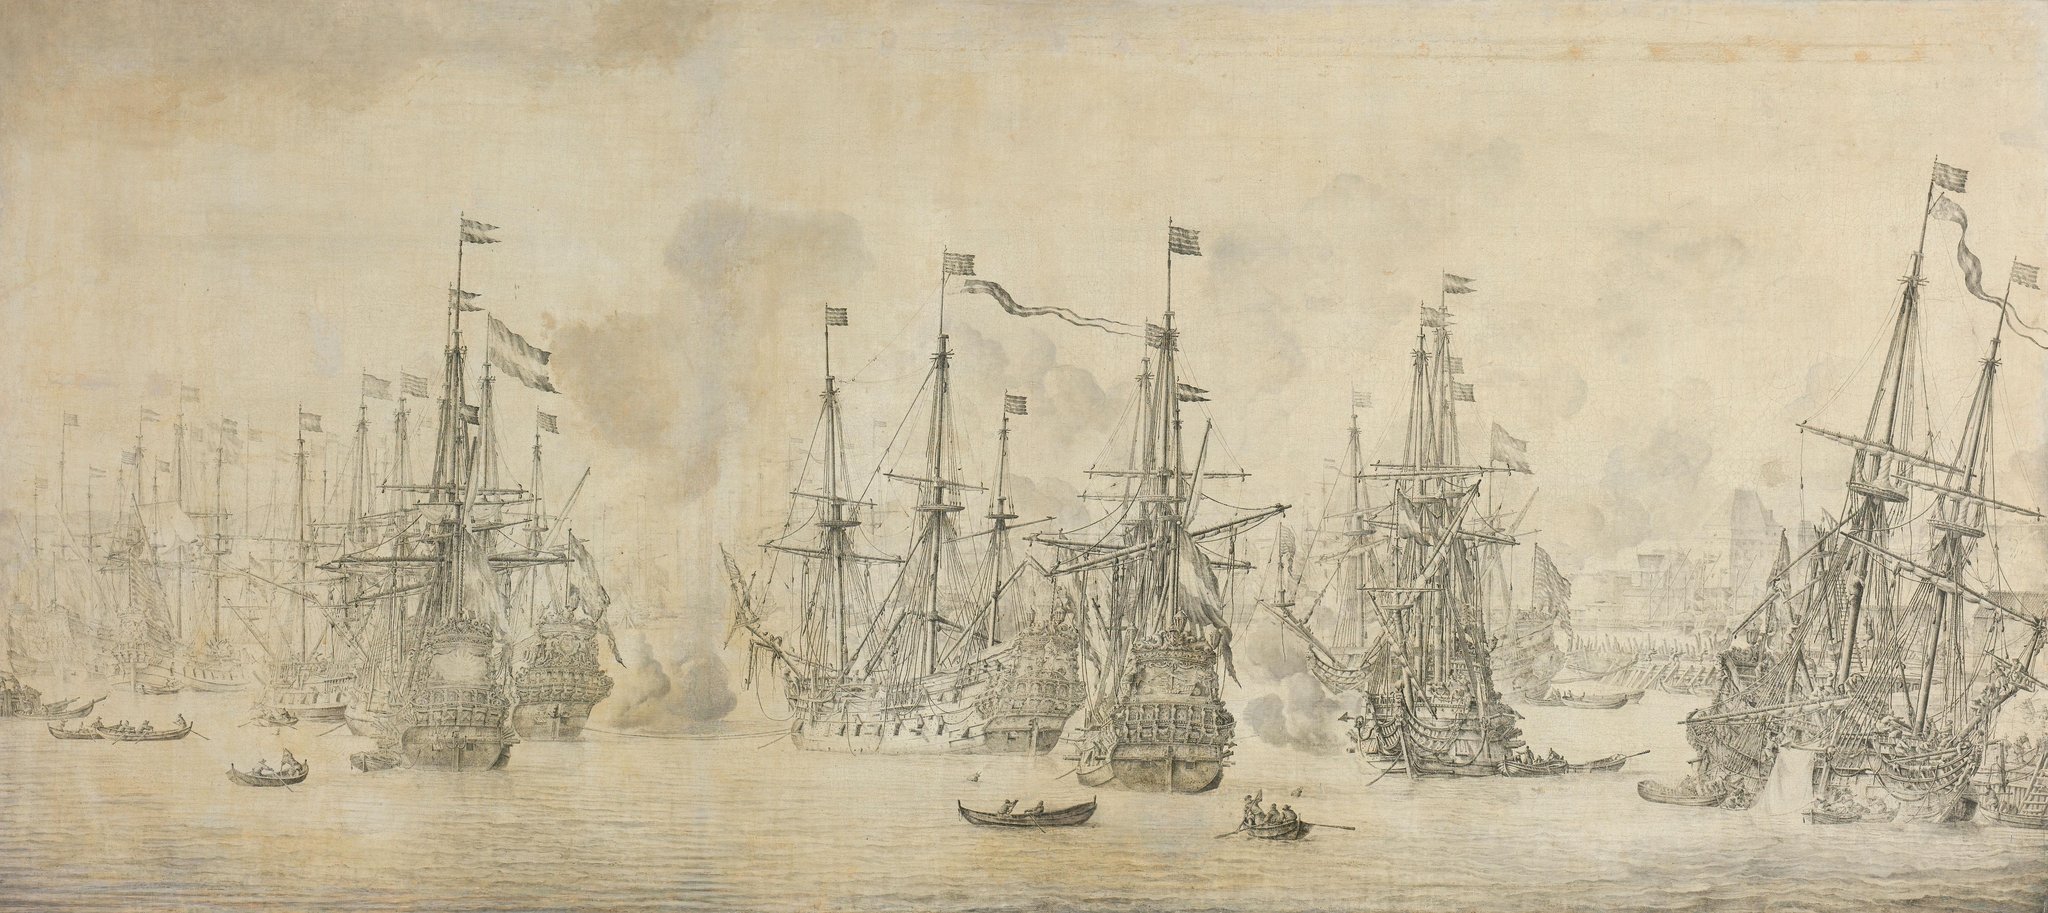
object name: painting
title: "The Failed Attack of the English on the Return Fleet in the Port of Bergen, Norway, 12 August 1665: an episode from the Second Anglo-Dutch War"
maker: willem van de velde (i)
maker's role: draughtsman, painter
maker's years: 1611-1693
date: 1669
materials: canvas, ink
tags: sailing-ship, sailing-boat, navy, battle (+ sailing-ships)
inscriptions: signature and date: ‘W. v.d. Velde f. 1669’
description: Het oorspronkelijke schilderij is op enig moment, wanneer onbekend, in drie stukken gesneden. Het linker deel is in 1958 door het National Maritime Museum te Greenwich (GB) aan het Rijksmuseum geschonken, dat sinds 1887 het rechter deel bezit. Een derde afgesneden gedeelte is tot op heden niet getraceerd. Gebaseerd op een schets naar het leven door Willem van de Velde (I) die zich in de collectie van Museum Boijmans Van Beuningen te Rotterdam bevindt, die een goede indruk van de schermutselingen geeft.